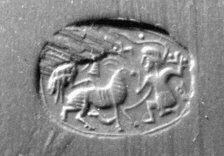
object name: stamp seal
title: Stamp seal (scarab) with two-figure contest scene (?)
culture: syro-anatolian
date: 800-601 BCE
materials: mineral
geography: northern syria or southeastern anatolia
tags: animals